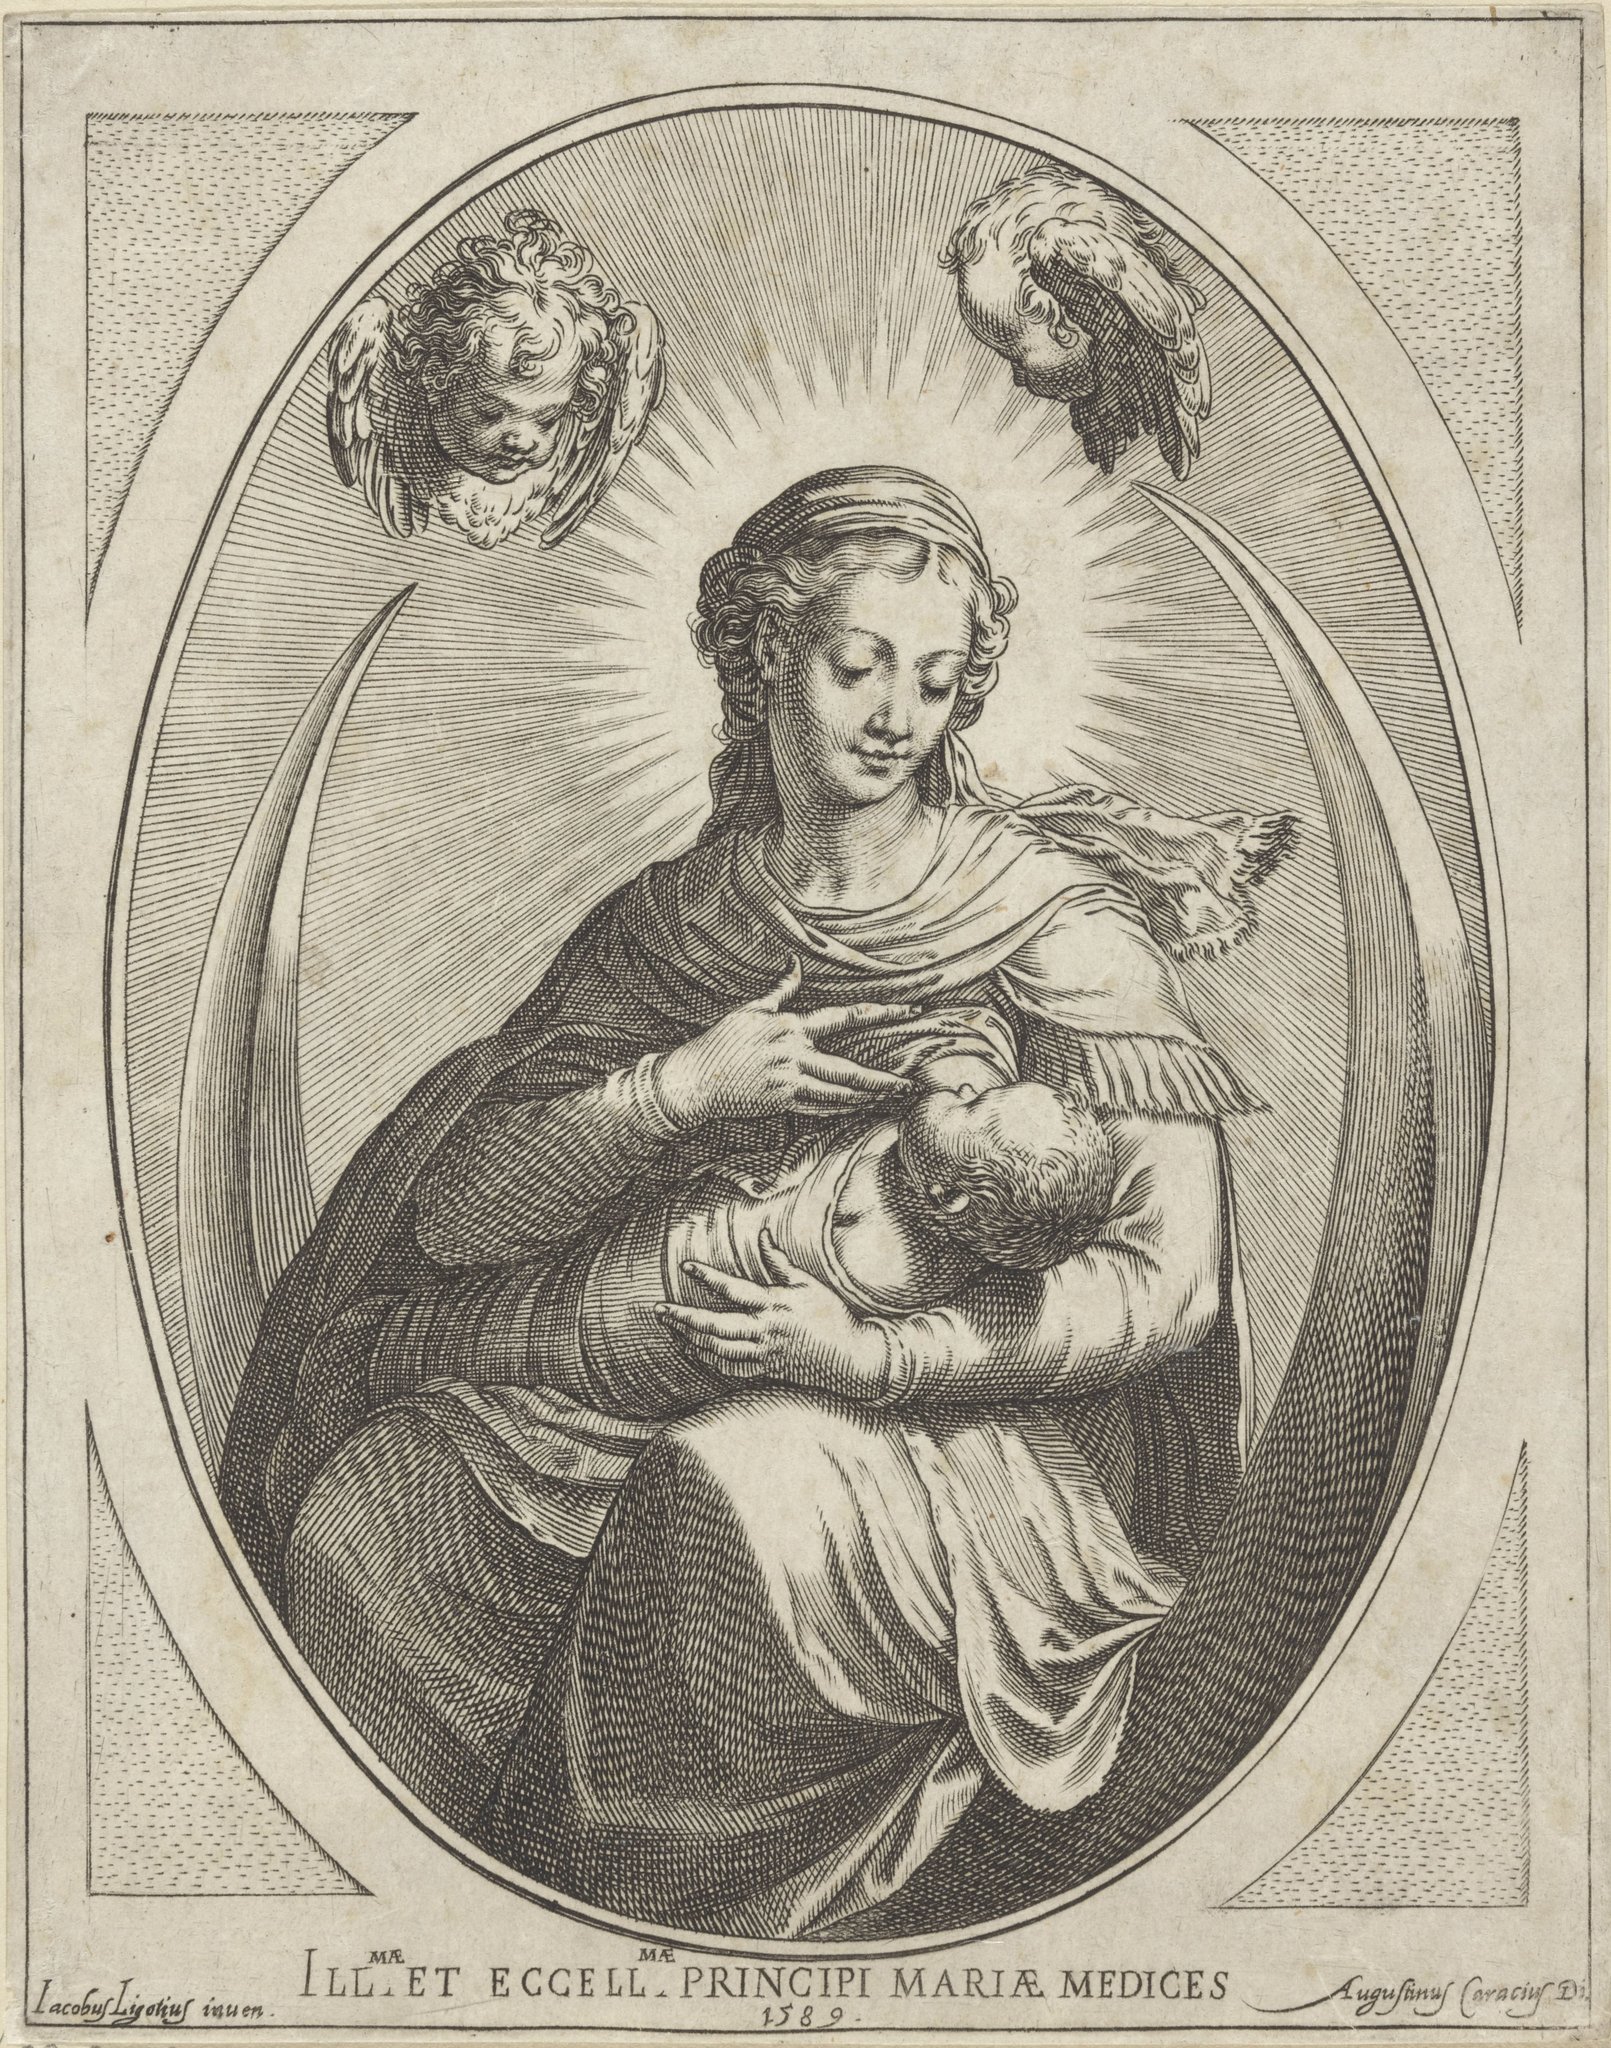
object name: print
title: Maria met Kind op maansikkel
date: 1589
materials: paper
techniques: engraving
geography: italy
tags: madonna on the crescent of the moon (sometimes called queen of heaven) (in mandorla)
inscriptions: collector's mark: Lugt 240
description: Maria zoogt het Christuskind en zit op een maansikkel. Boven twee cherubijnen.